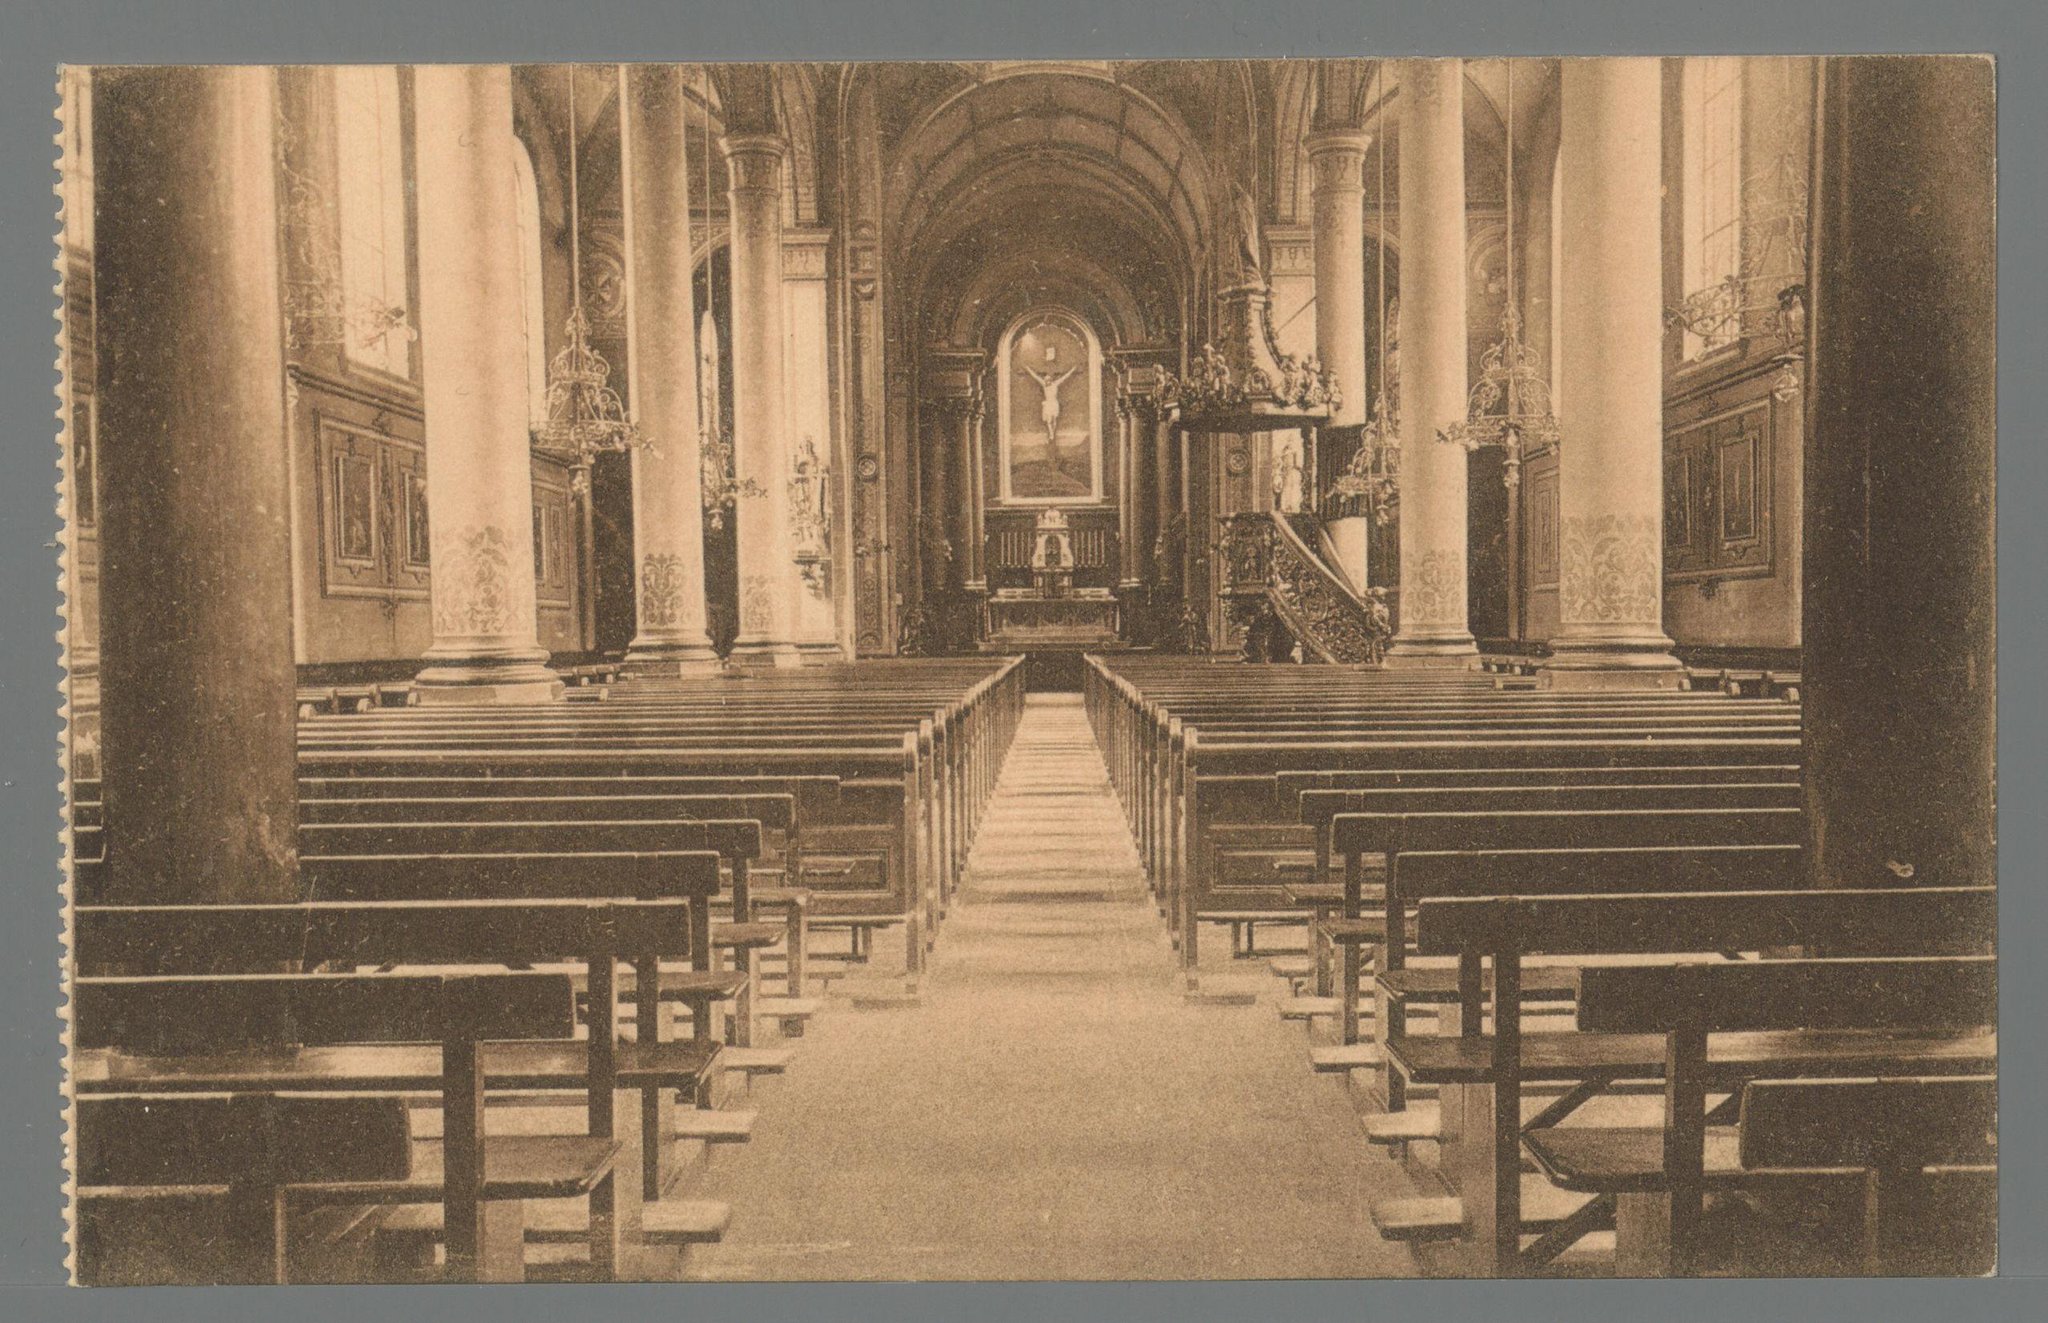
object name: ansichtkaart, prentbriefkaart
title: Interieur der Parochiekerk St. Dominicus, Utrecht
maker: Anonymous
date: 1905-1930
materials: cardboard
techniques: photograph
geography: utrecht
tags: interior of church